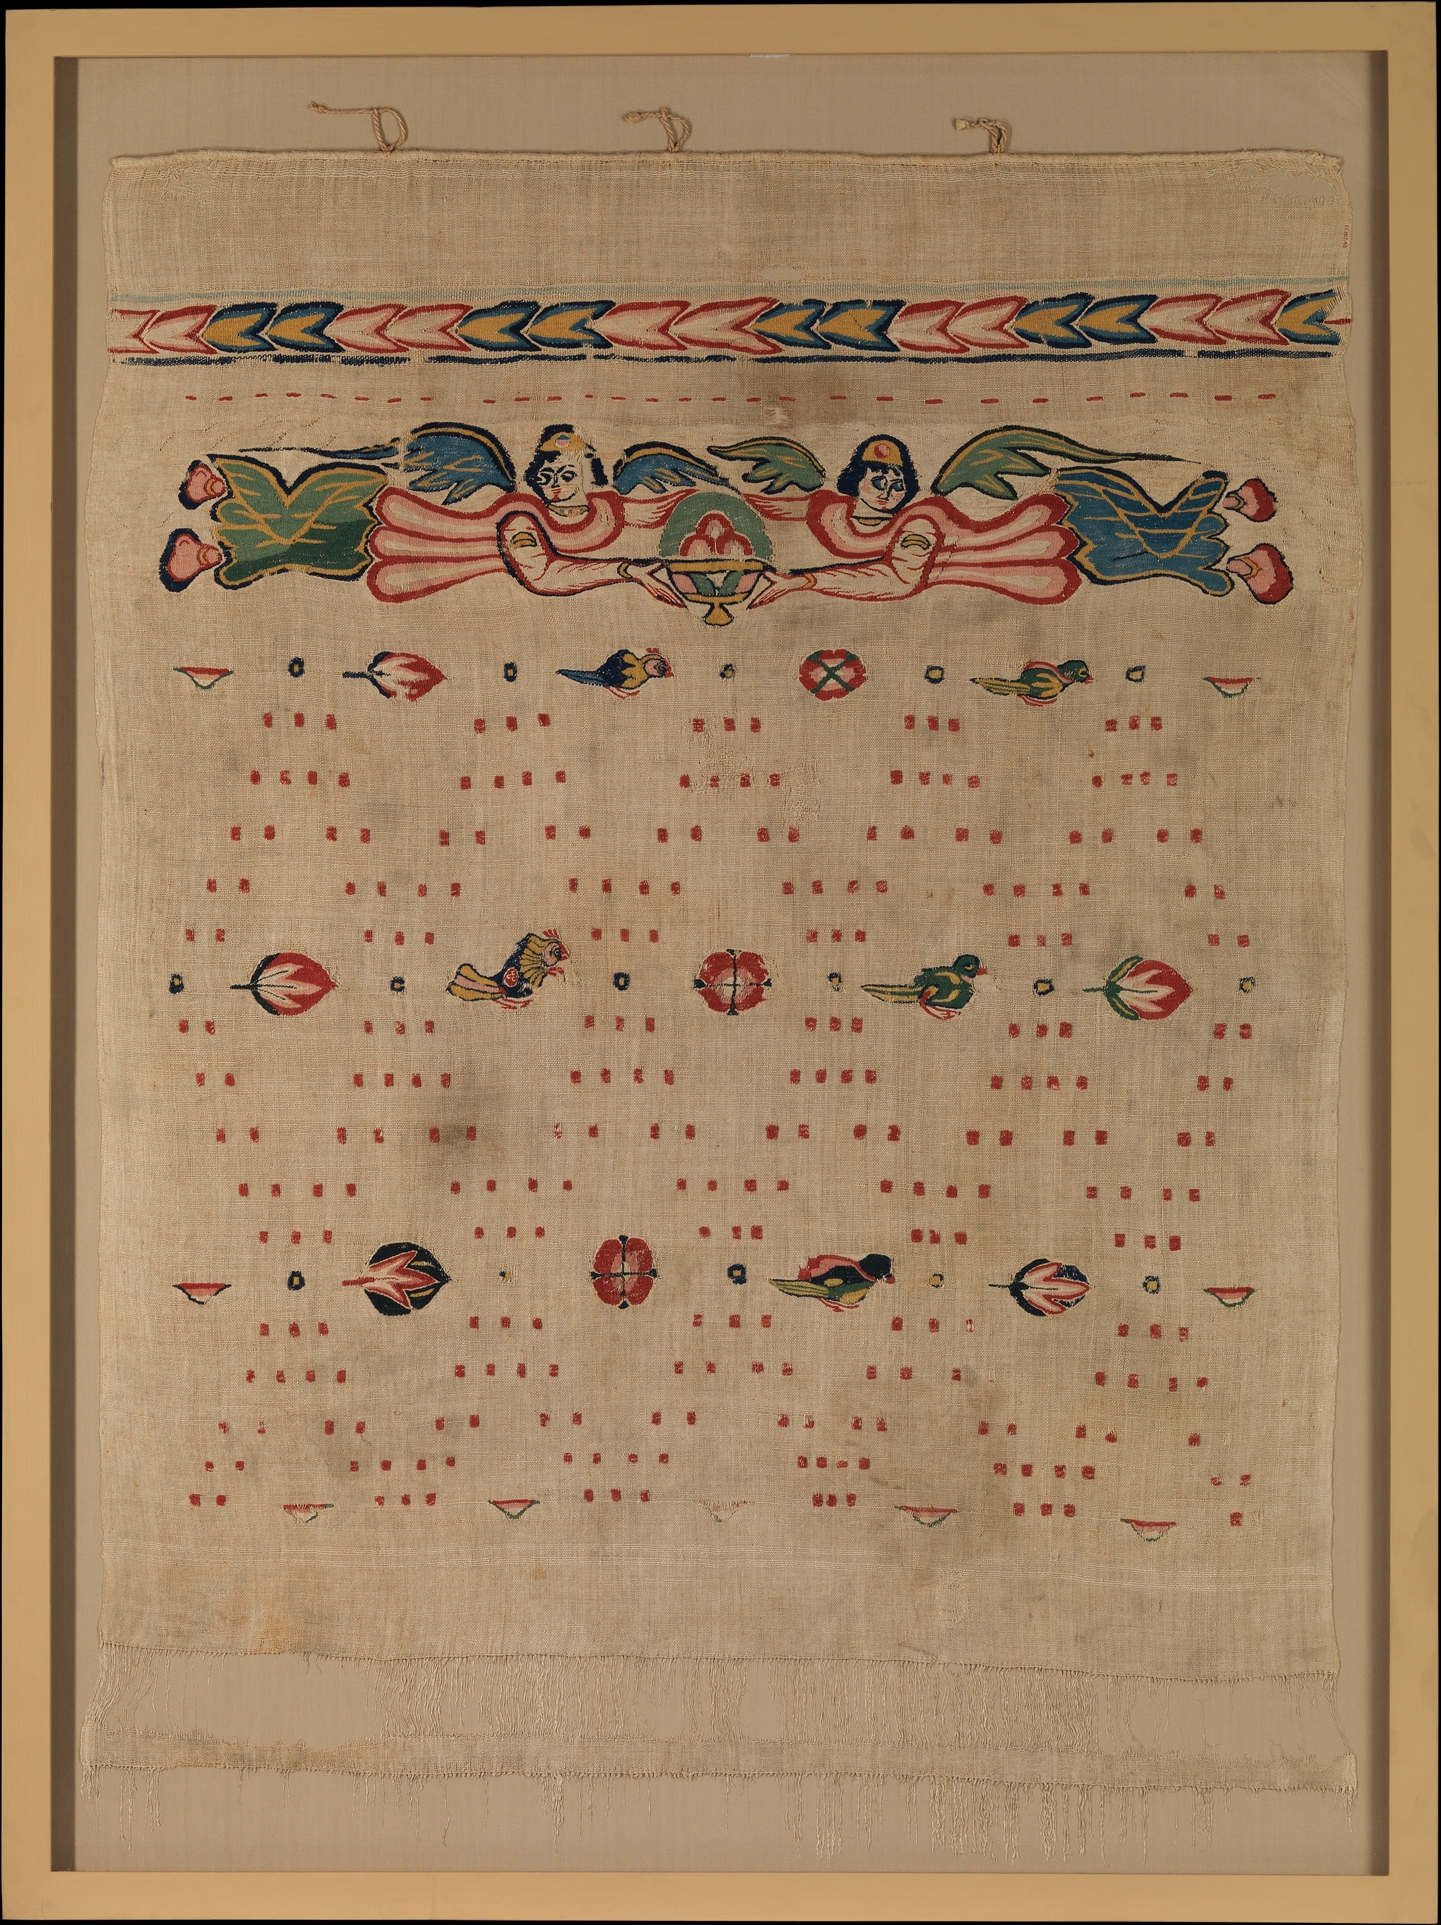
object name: hanging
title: Hanging with Nikes Holding Bowl of Fruit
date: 501-700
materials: linen, wool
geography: egypt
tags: birds,nike